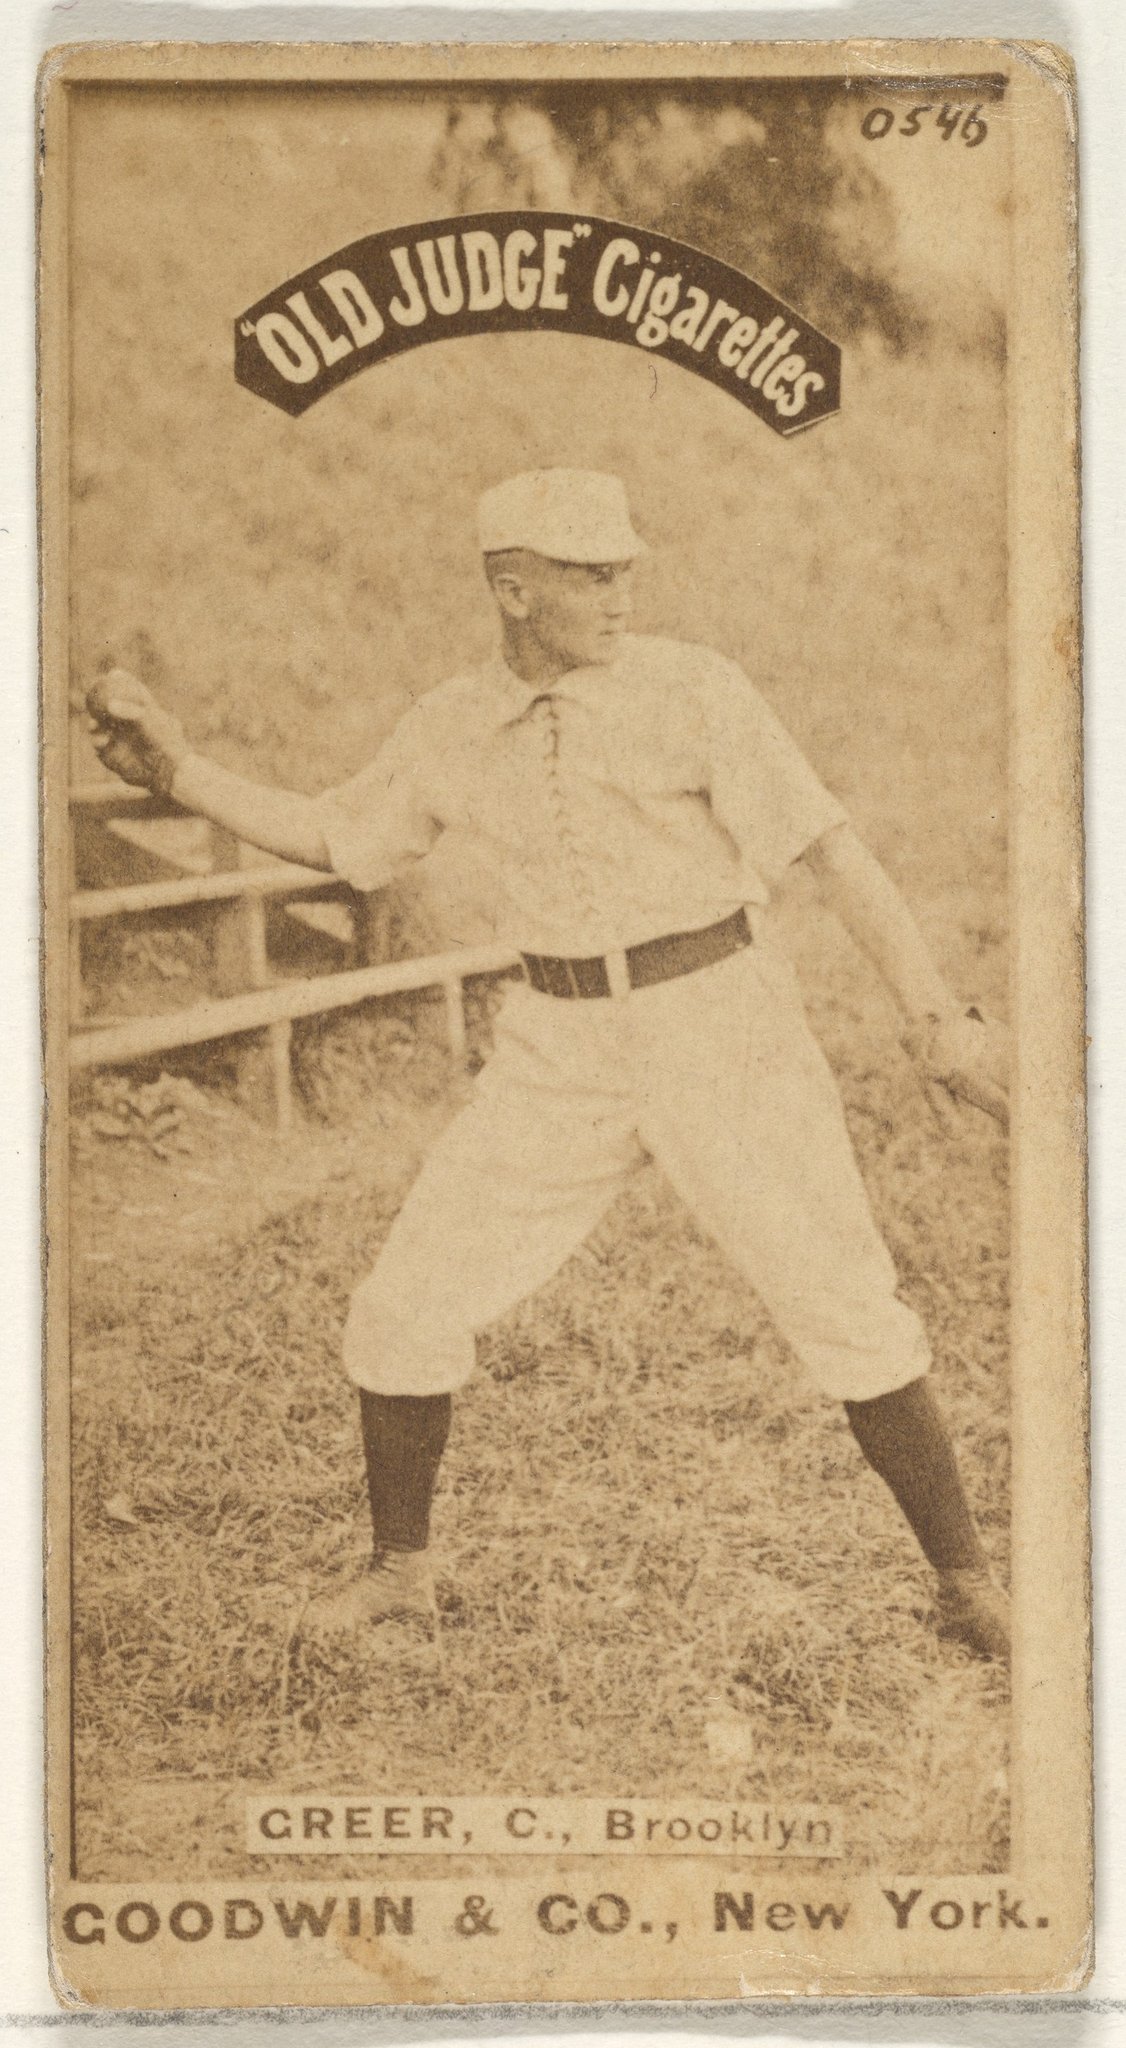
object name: baseball card, photograph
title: Greer, Catcher, Brooklyn, from the Old Judge series (N172) for Old Judge Cigarettes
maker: goodwin & company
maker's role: publisher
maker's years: 1850-1950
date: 1887-1890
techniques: albumen silver print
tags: men,portraits,baseball,athletes